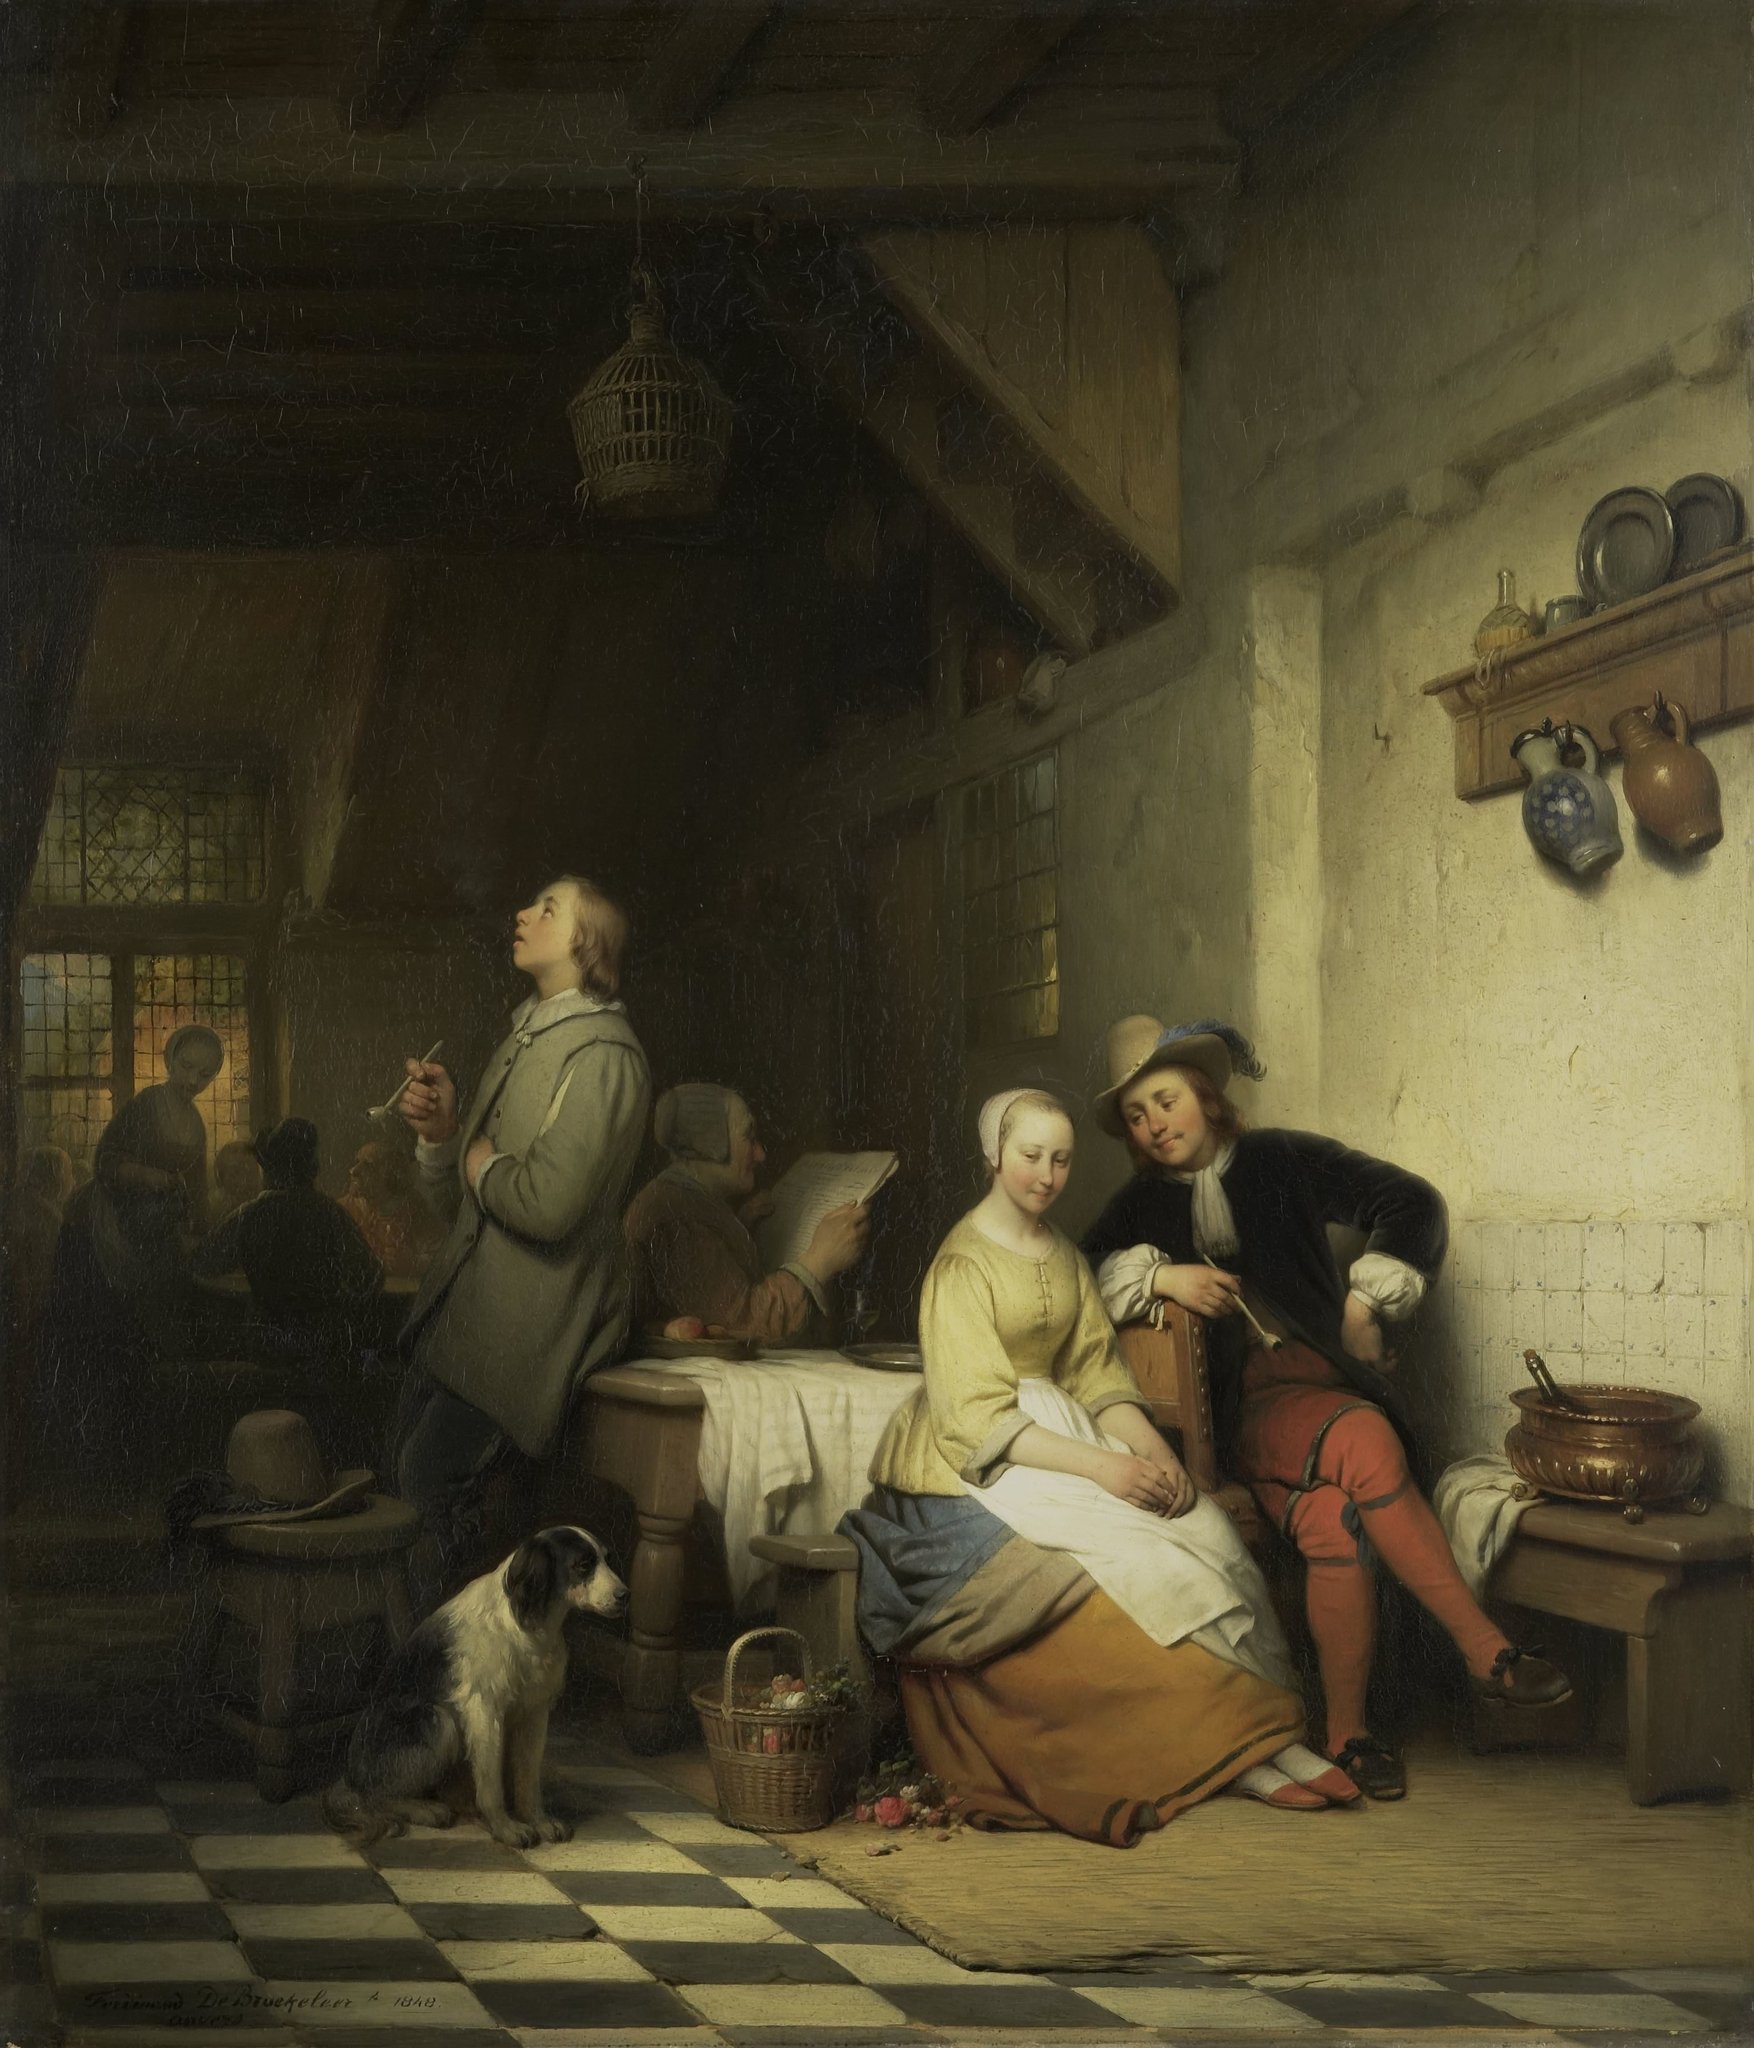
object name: painting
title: Interior of an Inn, with Figures in Seventeenth-Century Costume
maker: ferdinand de braekeleer (i)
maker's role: draughtsman, print maker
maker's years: 1792-1883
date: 1848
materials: oil, panel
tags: inn, coffee-house, public house, etc., courting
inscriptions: signature and date: ‘Ferdinand de Braekeleer Anvers A 1848’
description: Herberginterieur met figuren in zeventiende-eeuws kostuum. Bij een tafel maakt een jonge man een jonge vrouw het hof. Links een man die een pijp rookt, bij zijn voeten zit een hond. Aan de muur een rek waaraan stenen kruiken hangen.